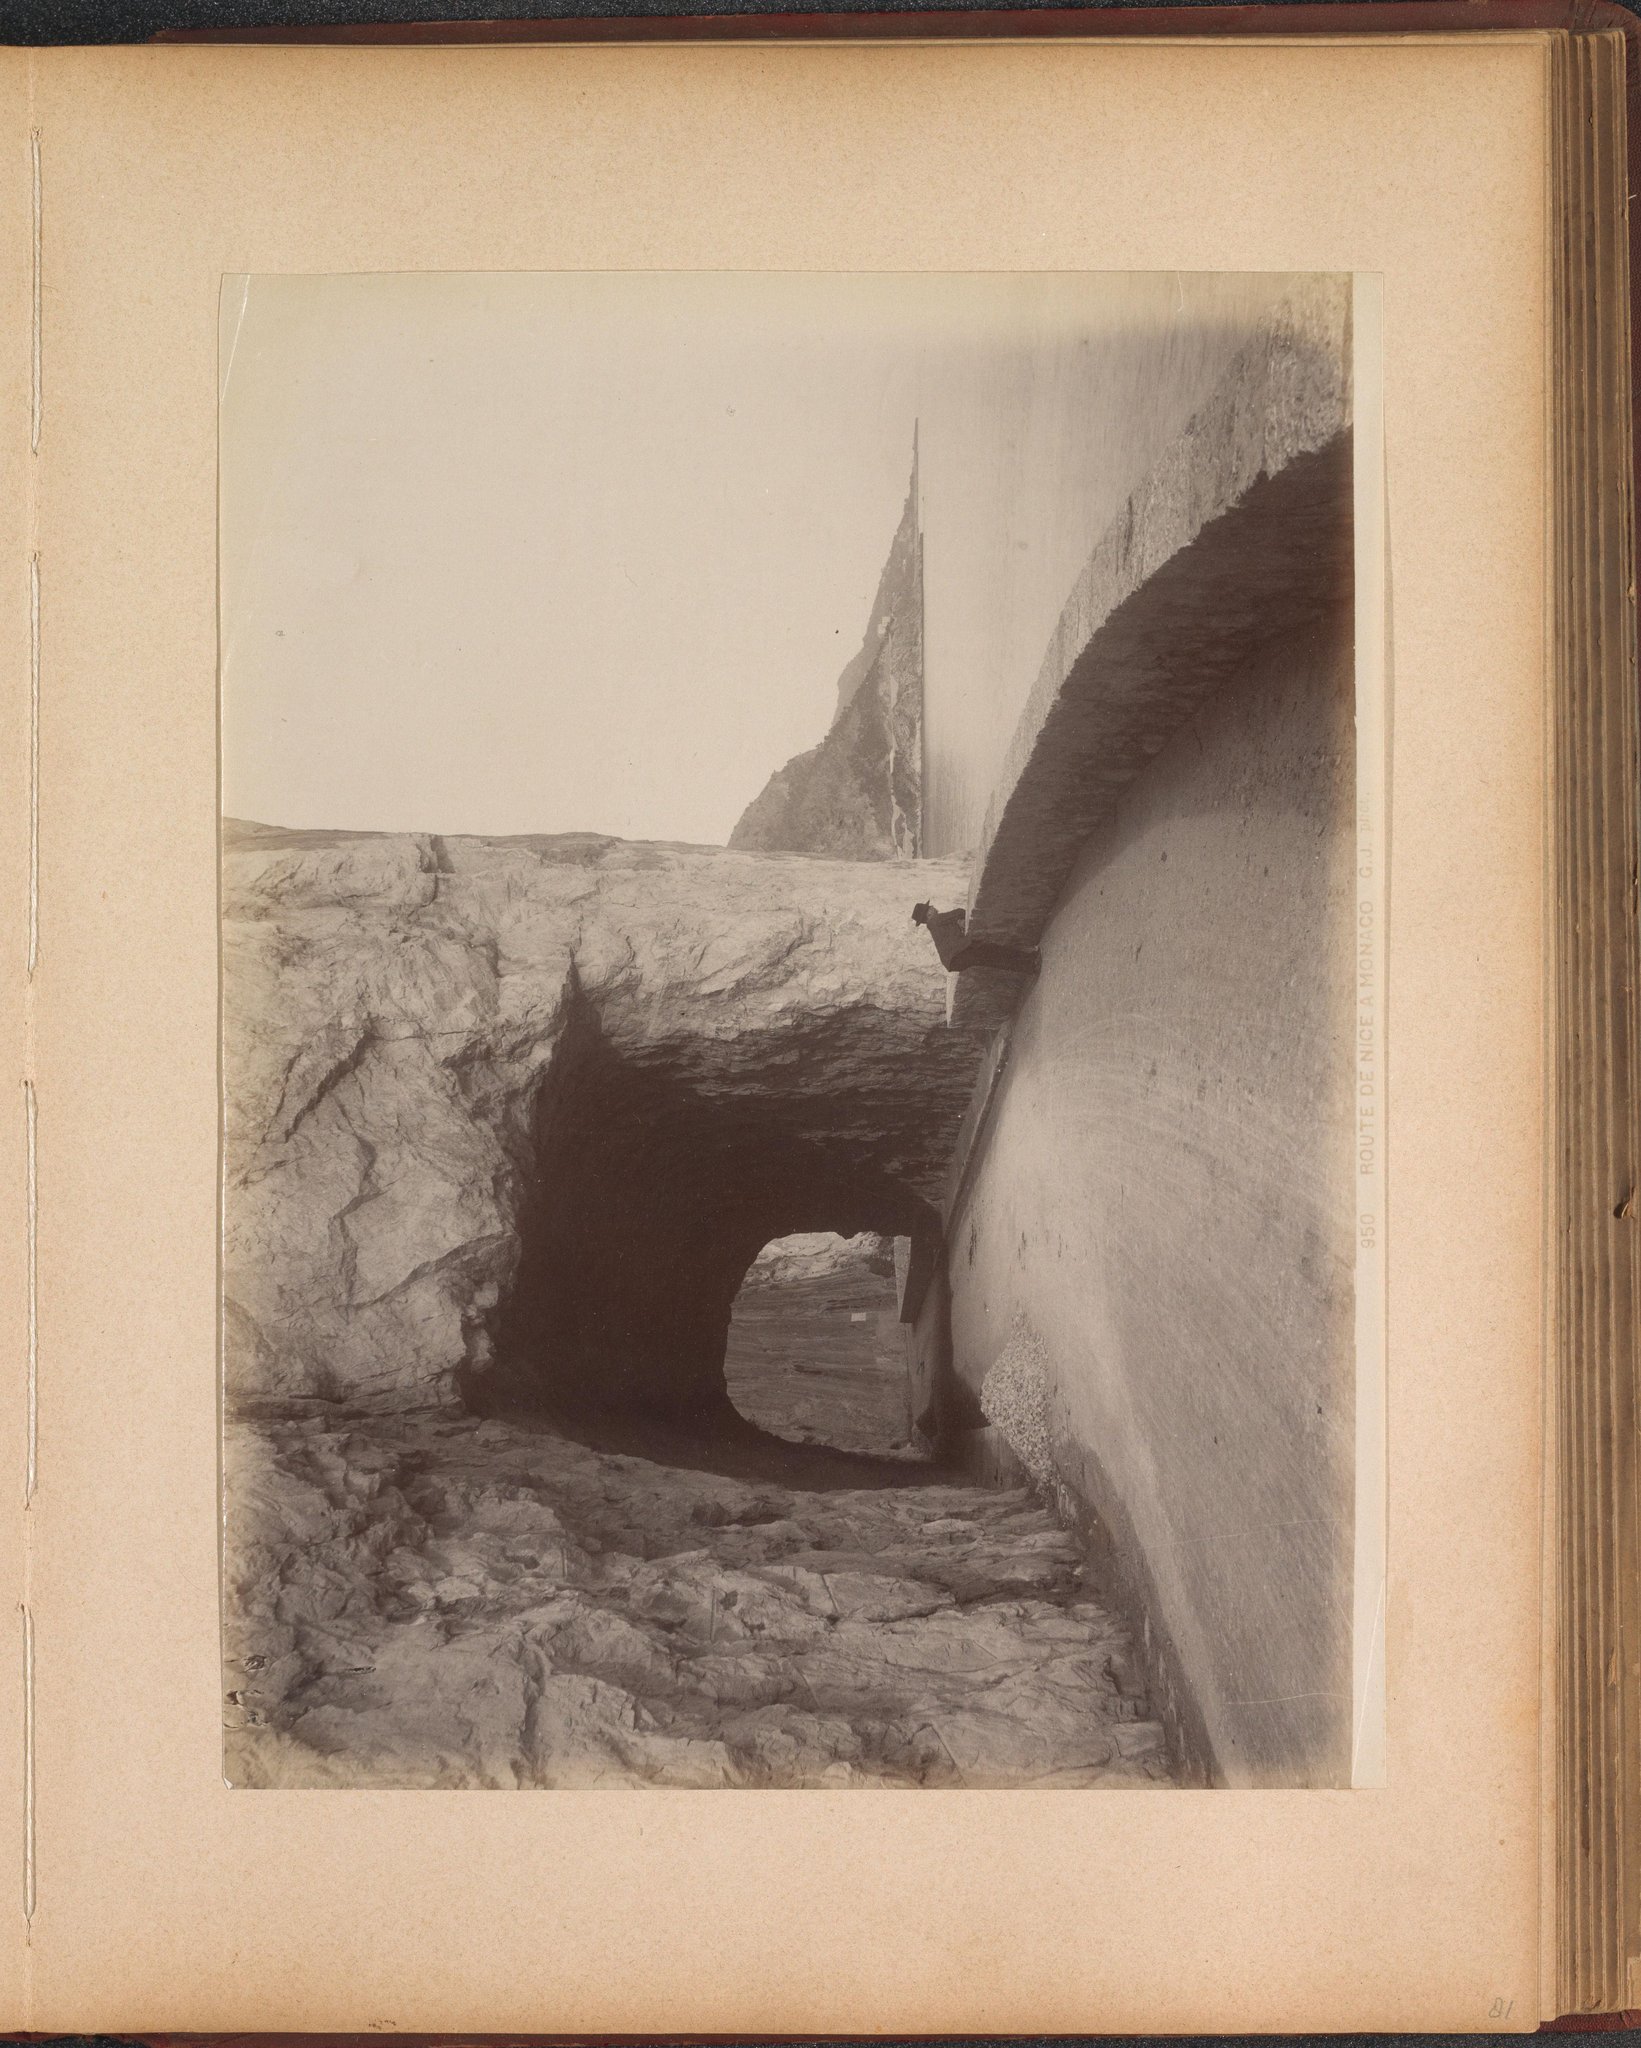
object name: photograph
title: Weg en tunnel aan de kust van Nice naar Monaco, op de voorgrond een man uitkijkend over zee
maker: jean gilletta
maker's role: fotograaf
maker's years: 1856-1933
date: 1870-1900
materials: paper, photographic support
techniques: albumen print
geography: provence-alpes-côte d'azur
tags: road, path, underground road, tunnel, coast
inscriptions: negative number: ‘950’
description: Onderdeel van Reisalbum met foto's van bezienswaardigheden in Italië en Zuid-Frankrijk.